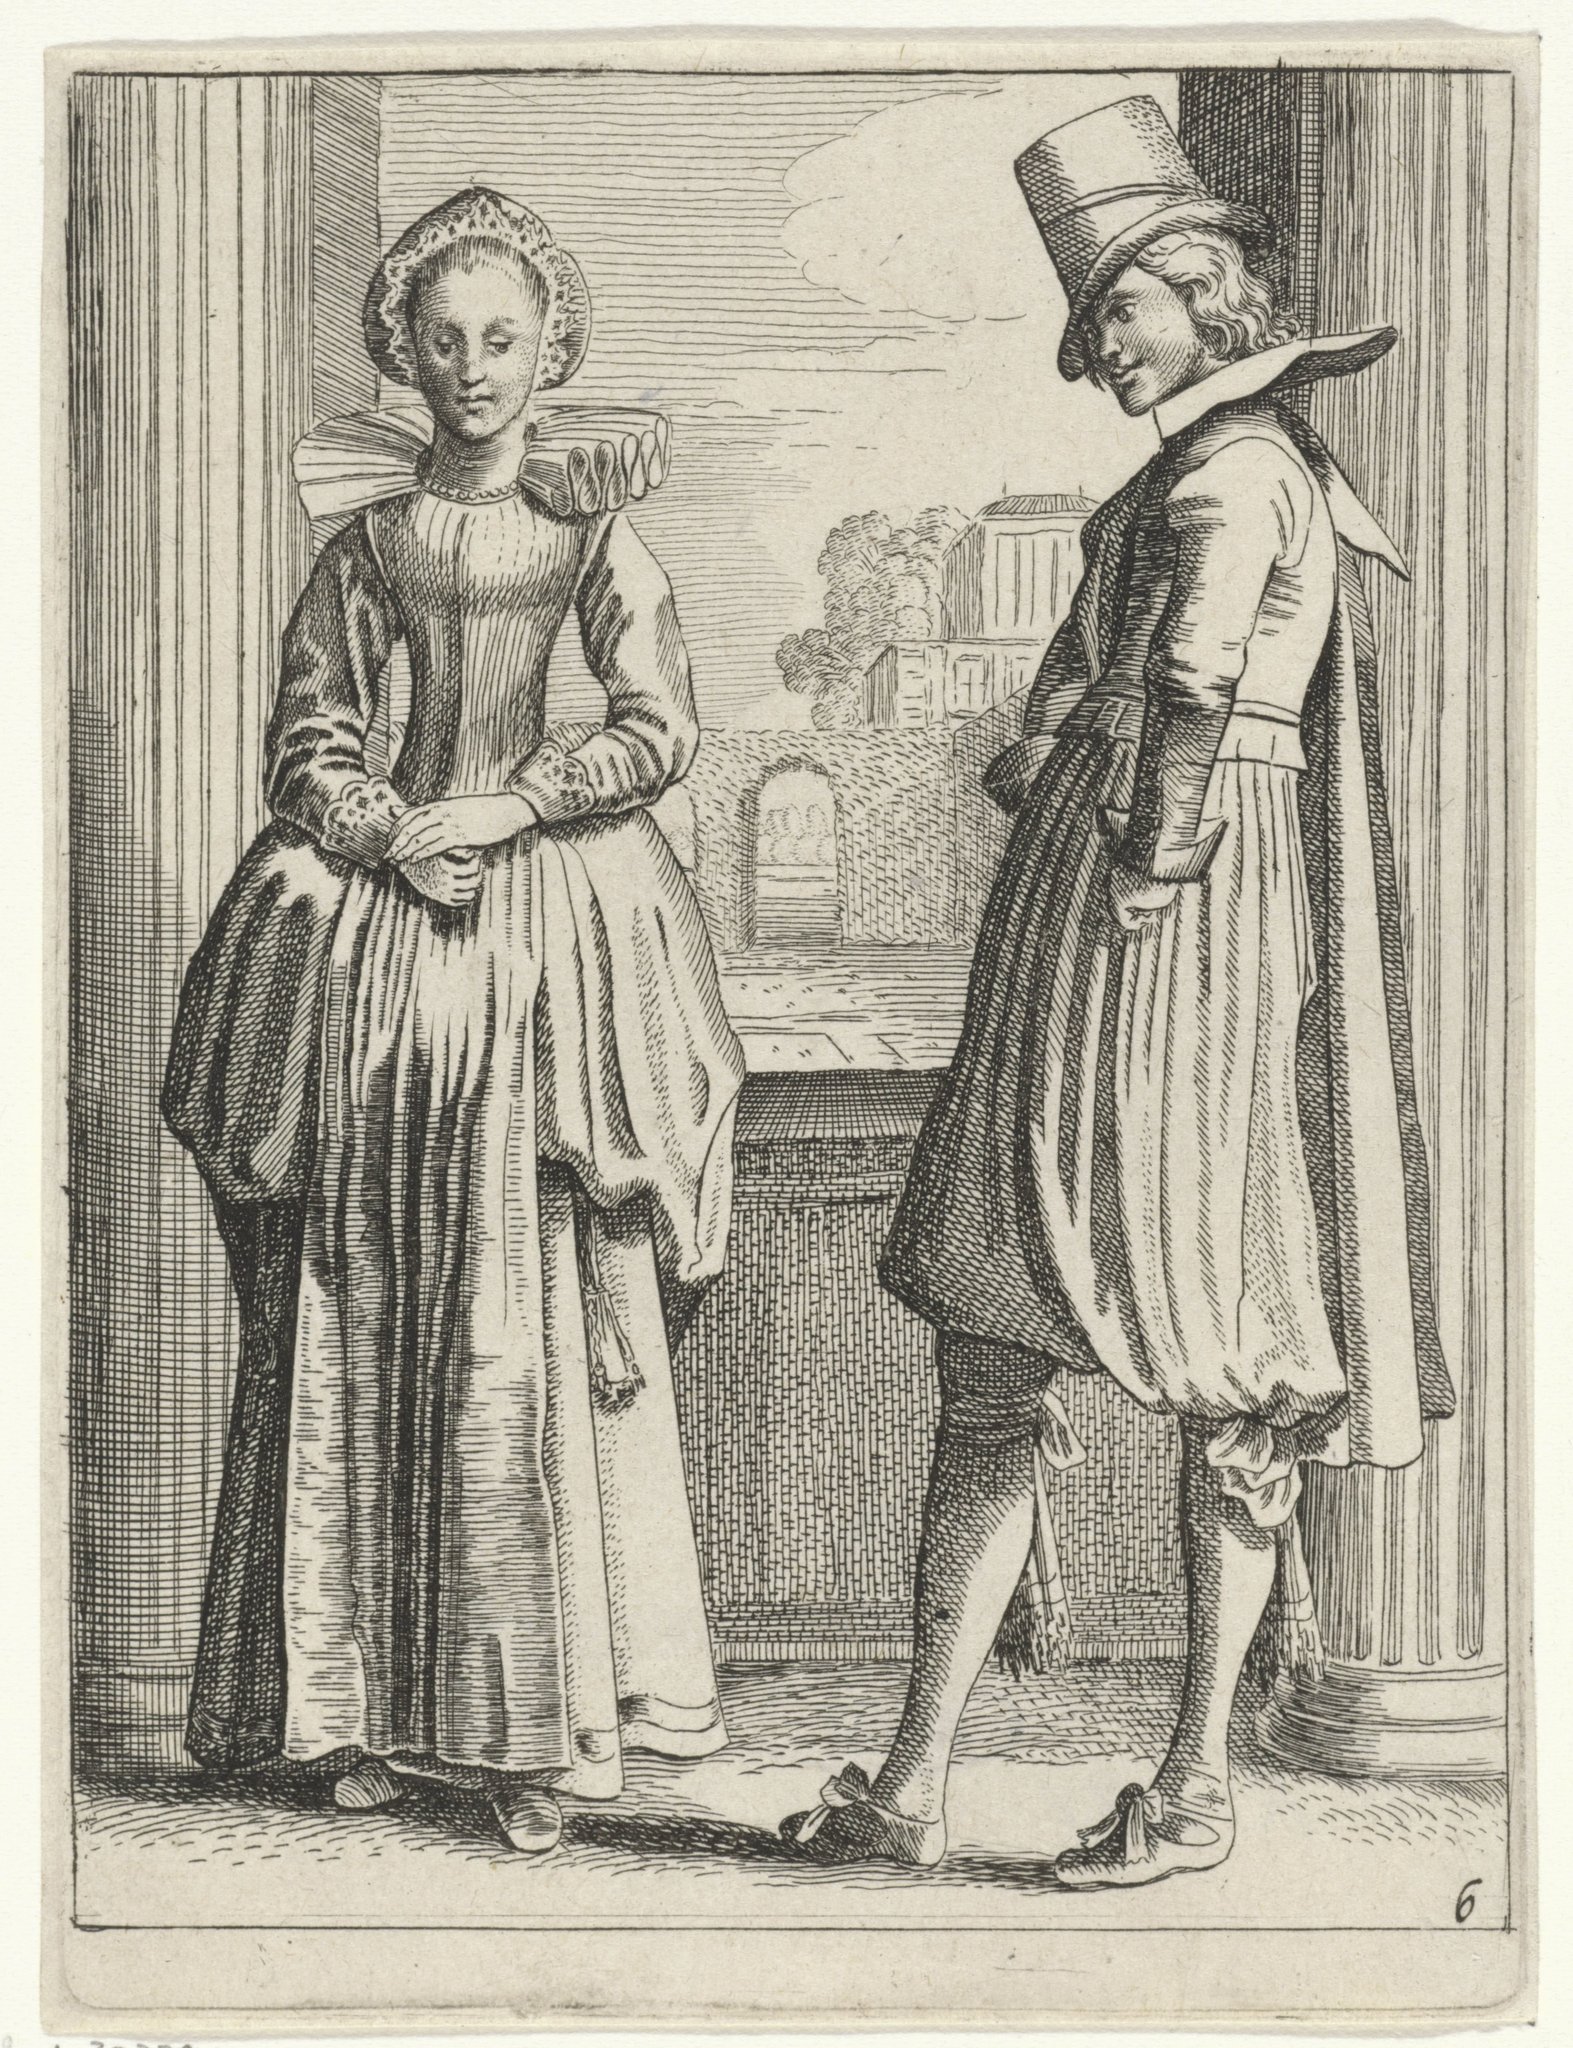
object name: costume print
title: Kostuums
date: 1603-1652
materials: paper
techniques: engraving, etching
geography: amsterdam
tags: cape (+ men's clothes), head-gear (boogmuts) (+ women's clothes), neck-gear: collar (+ women's clothes), clothes, costume (+ women's clothes), skirt (+ women's clothes), dress, gown (+ women's clothes), shoes, sandals (+ men's clothes), clothes, costume (+ men's clothes), neck-gear: collar (+ men's clothes), trousers, breeches, etc. (breeches) (+ men's clothes), clothing for the upper part of the body (doublet) (+ men's clothes), stockings, socks (+ men's clothes), clothing for the upper part of the body (with name) (+ women's clothes), netherlands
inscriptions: number: ‘6’, collector's mark: Lugt 964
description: Elegant gekleed paar, gekleed volgens de mode va. ca. 1620, staand op een bordes met zuilen. Zesde prent van een serie van acht kostuumprenten.